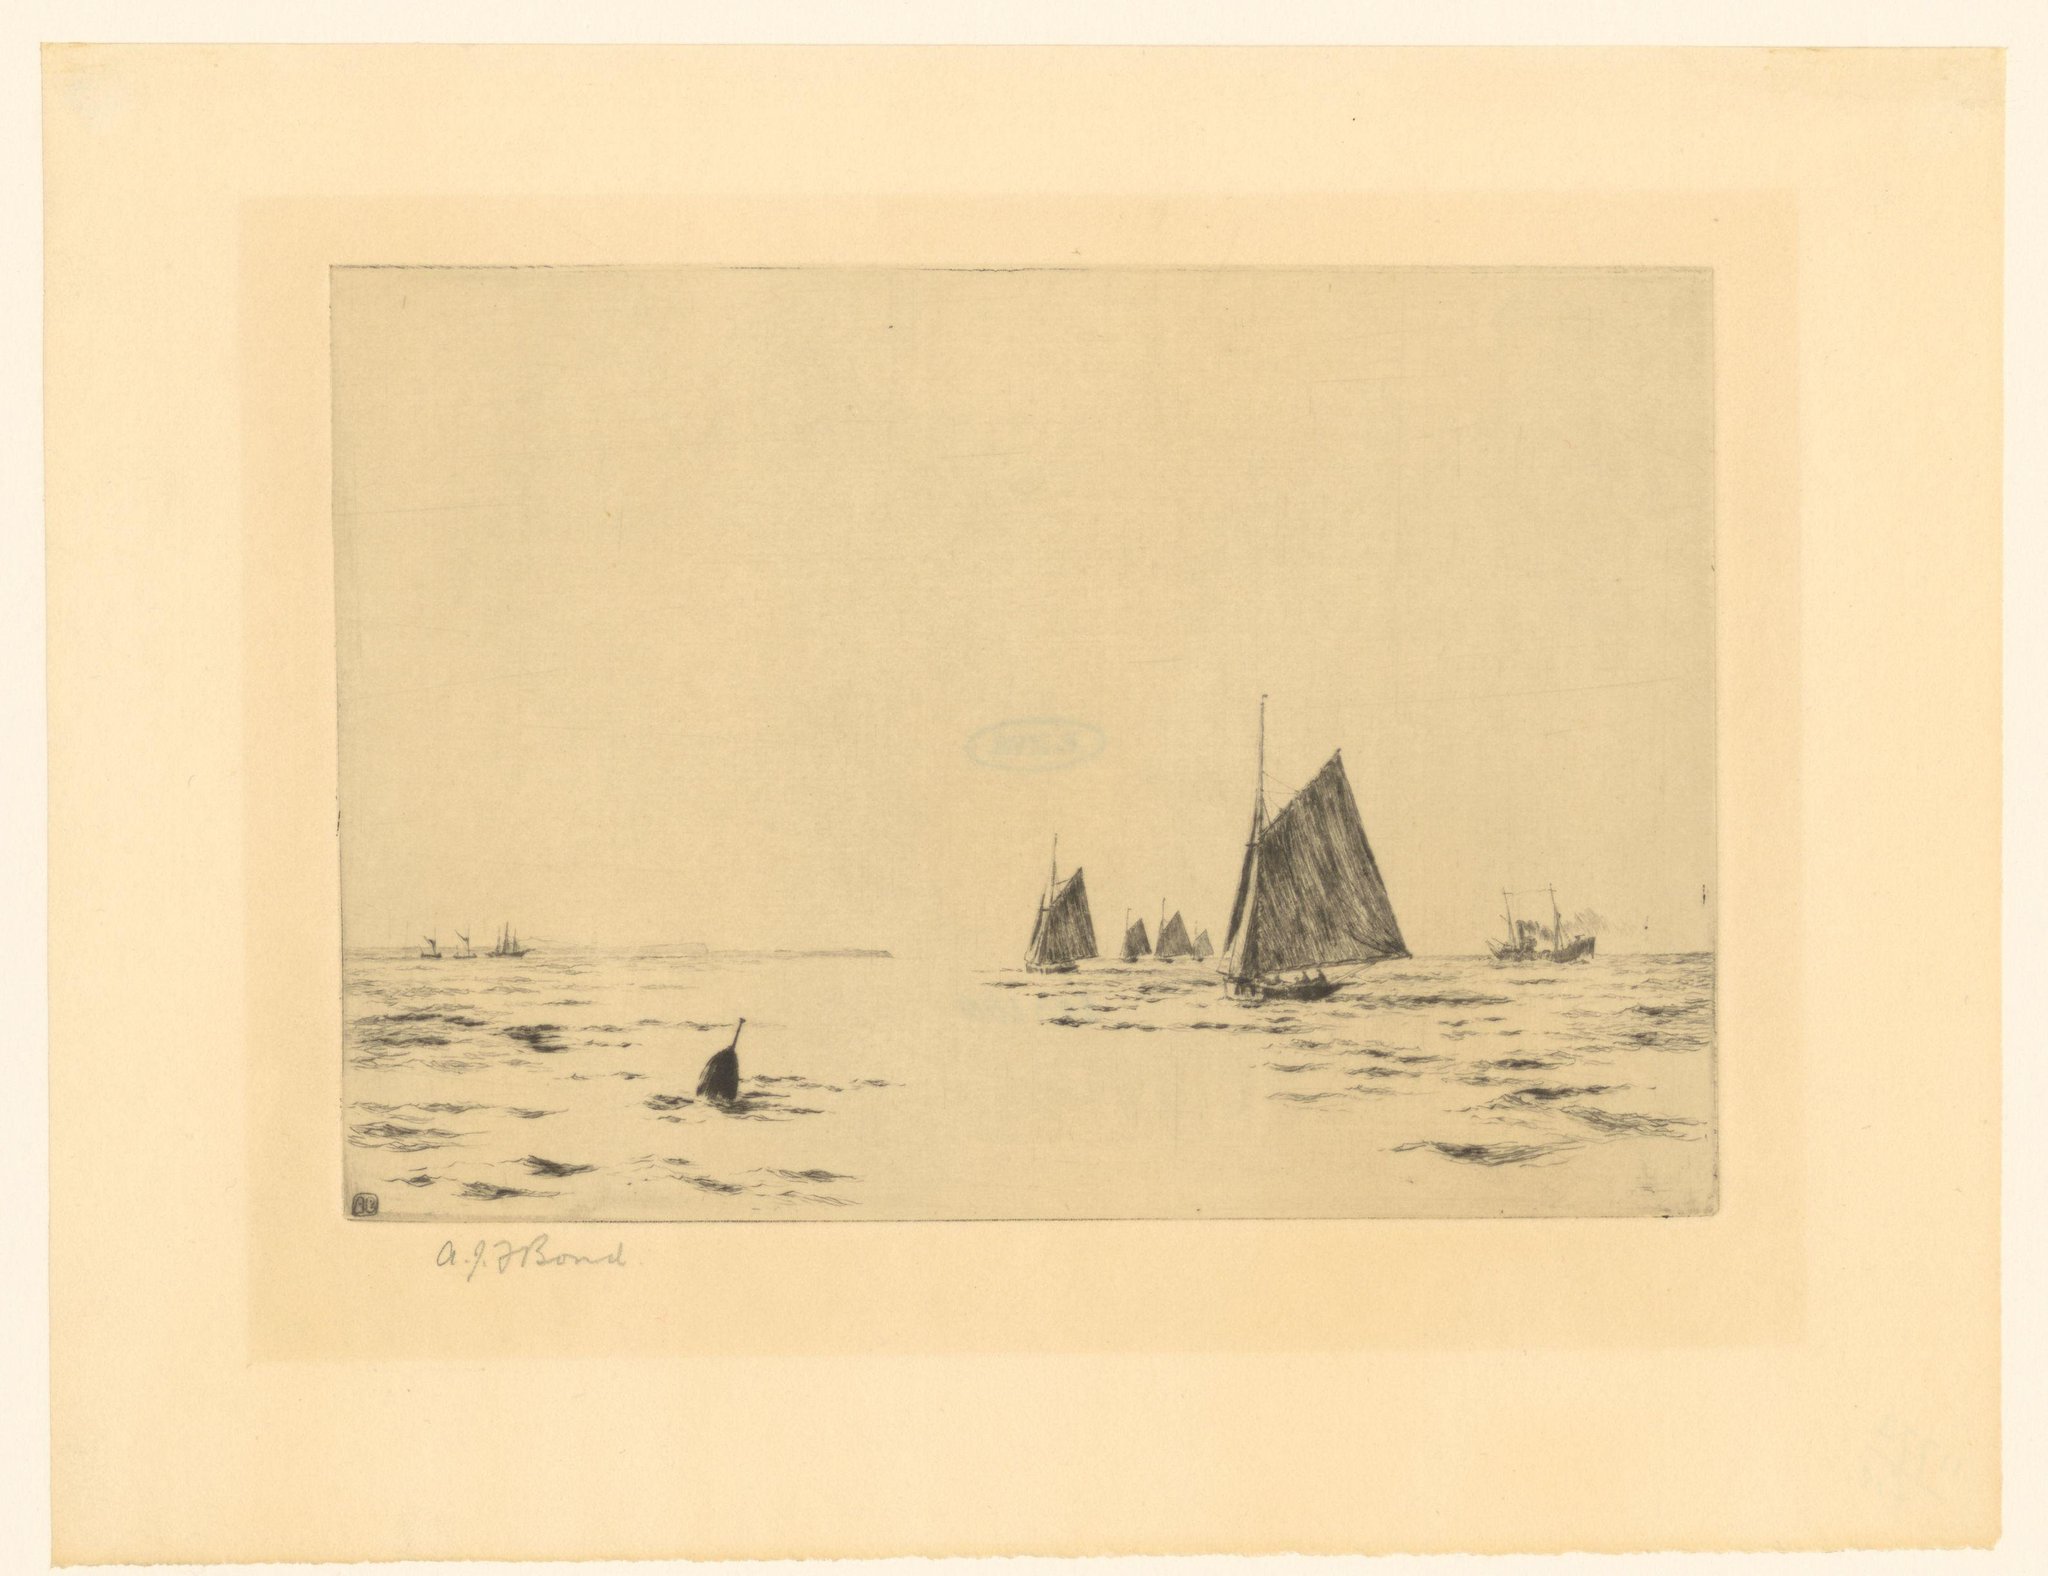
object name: print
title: Zeegezicht met zeilschepen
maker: a.j.j. bond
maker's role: print maker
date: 1900-1922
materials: paper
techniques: drypoint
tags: sailing-ship, sailing-boat, sea (seascape)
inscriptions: collector's mark: Lugt 2228